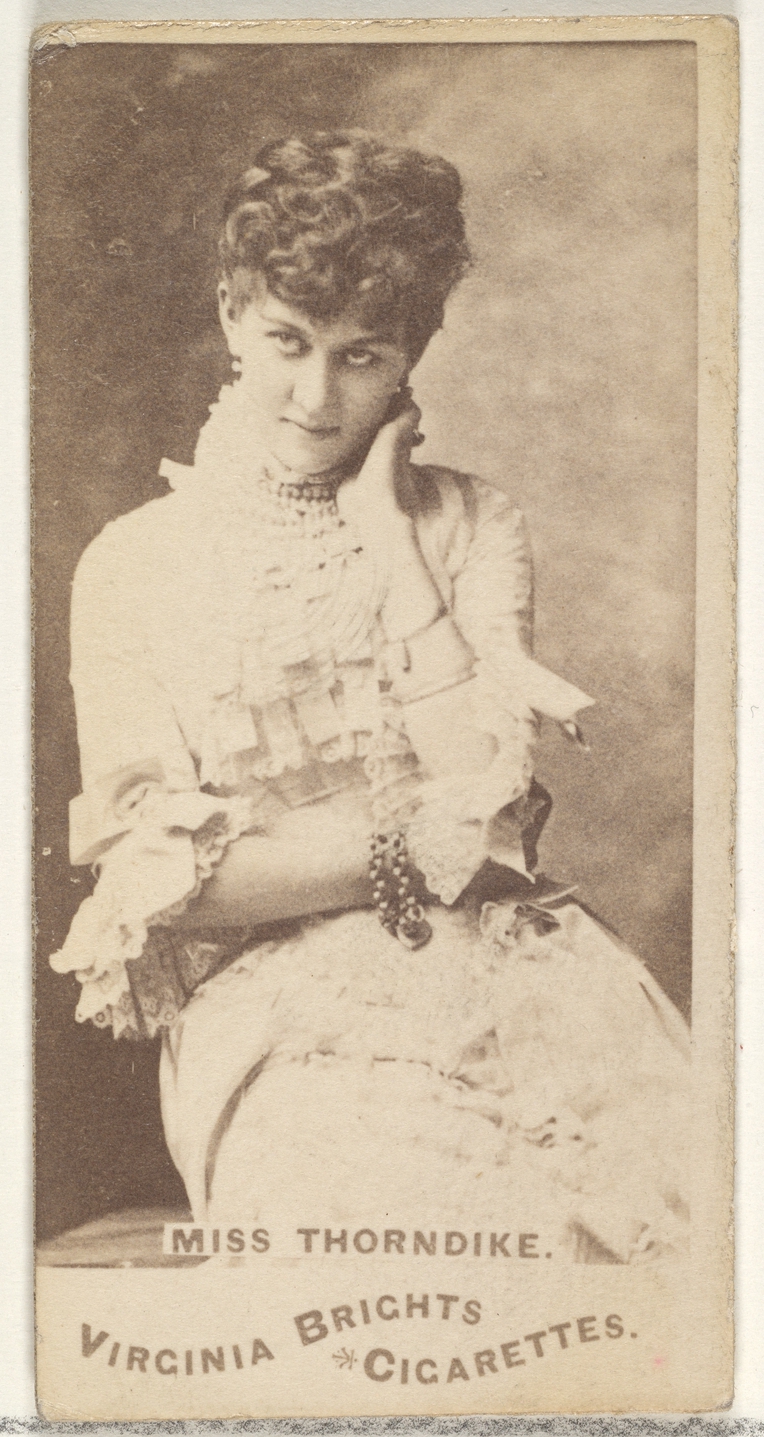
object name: photograph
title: Miss Thorndike, from the Actors and Actresses series (N45, Type 1) for Virginia Brights Cigarettes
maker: allen & ginter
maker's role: publisher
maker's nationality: american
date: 1888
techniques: albumen silver print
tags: portraits,women,actresses